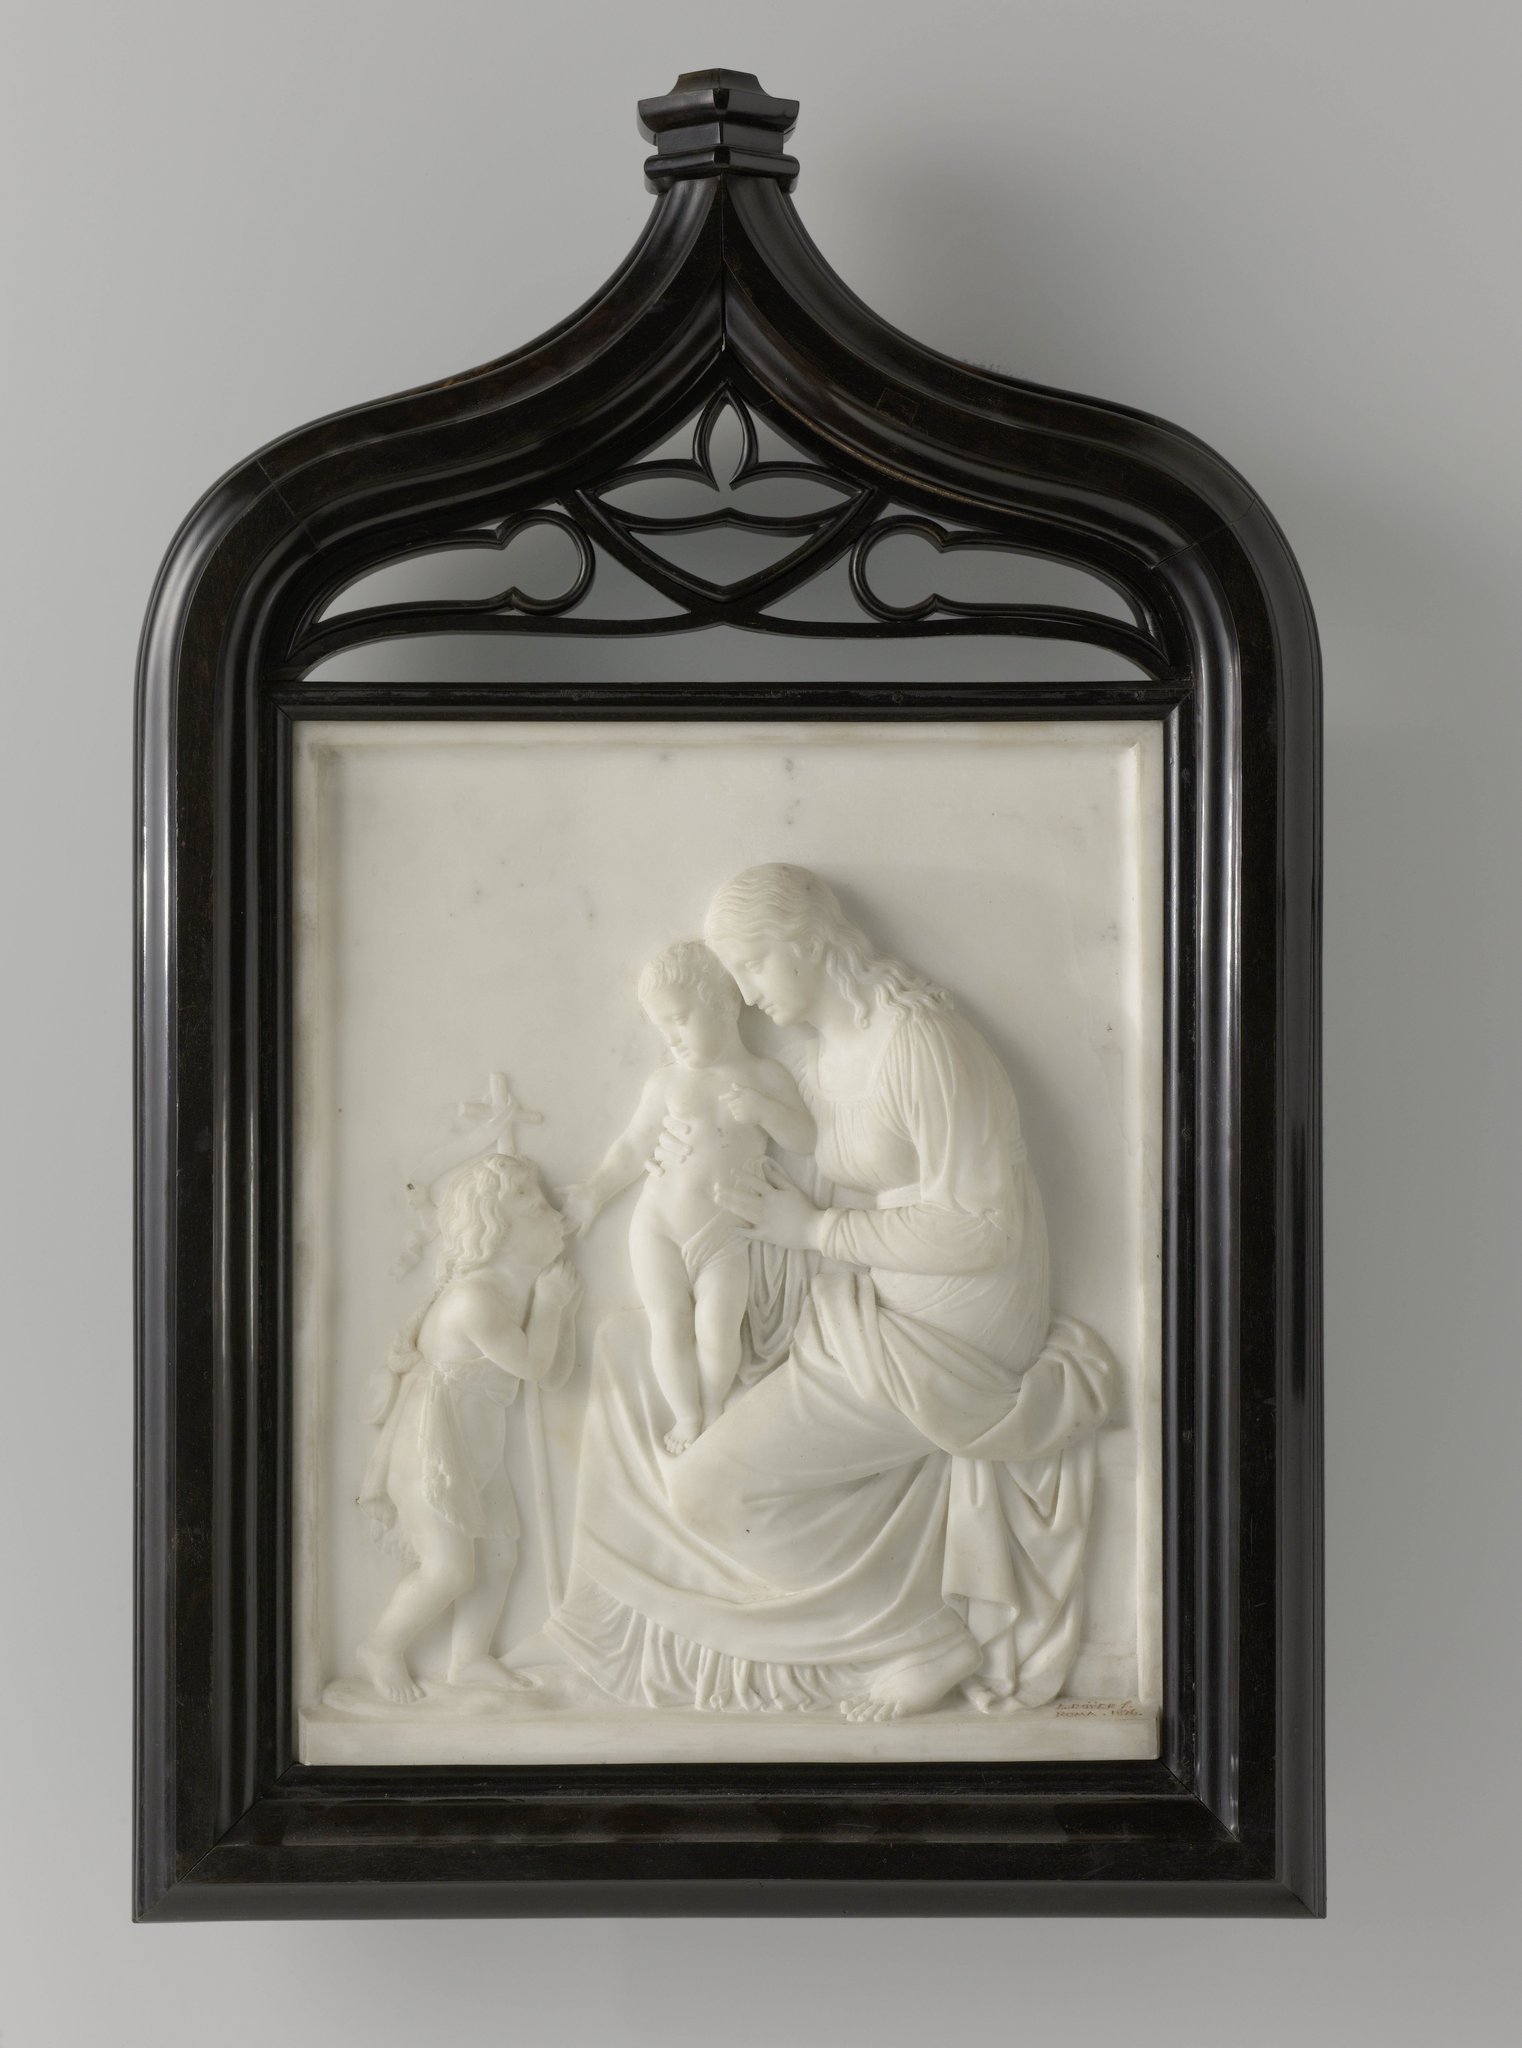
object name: sculpture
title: Maria met kind en Johannes de Doper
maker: louis royer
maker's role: draughtsman, sculptor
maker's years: 1793-1868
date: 1826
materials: marble, wood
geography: rome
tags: mary and the christ-child with john the baptist (as child)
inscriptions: signature and date: ‘L.ROIJER f. ROMA. 1826’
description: Louis Royer (1793 - 1868). The Virgin with Christ and St John the Baptist. Marble, in black wooden frame. Rome, 1826.